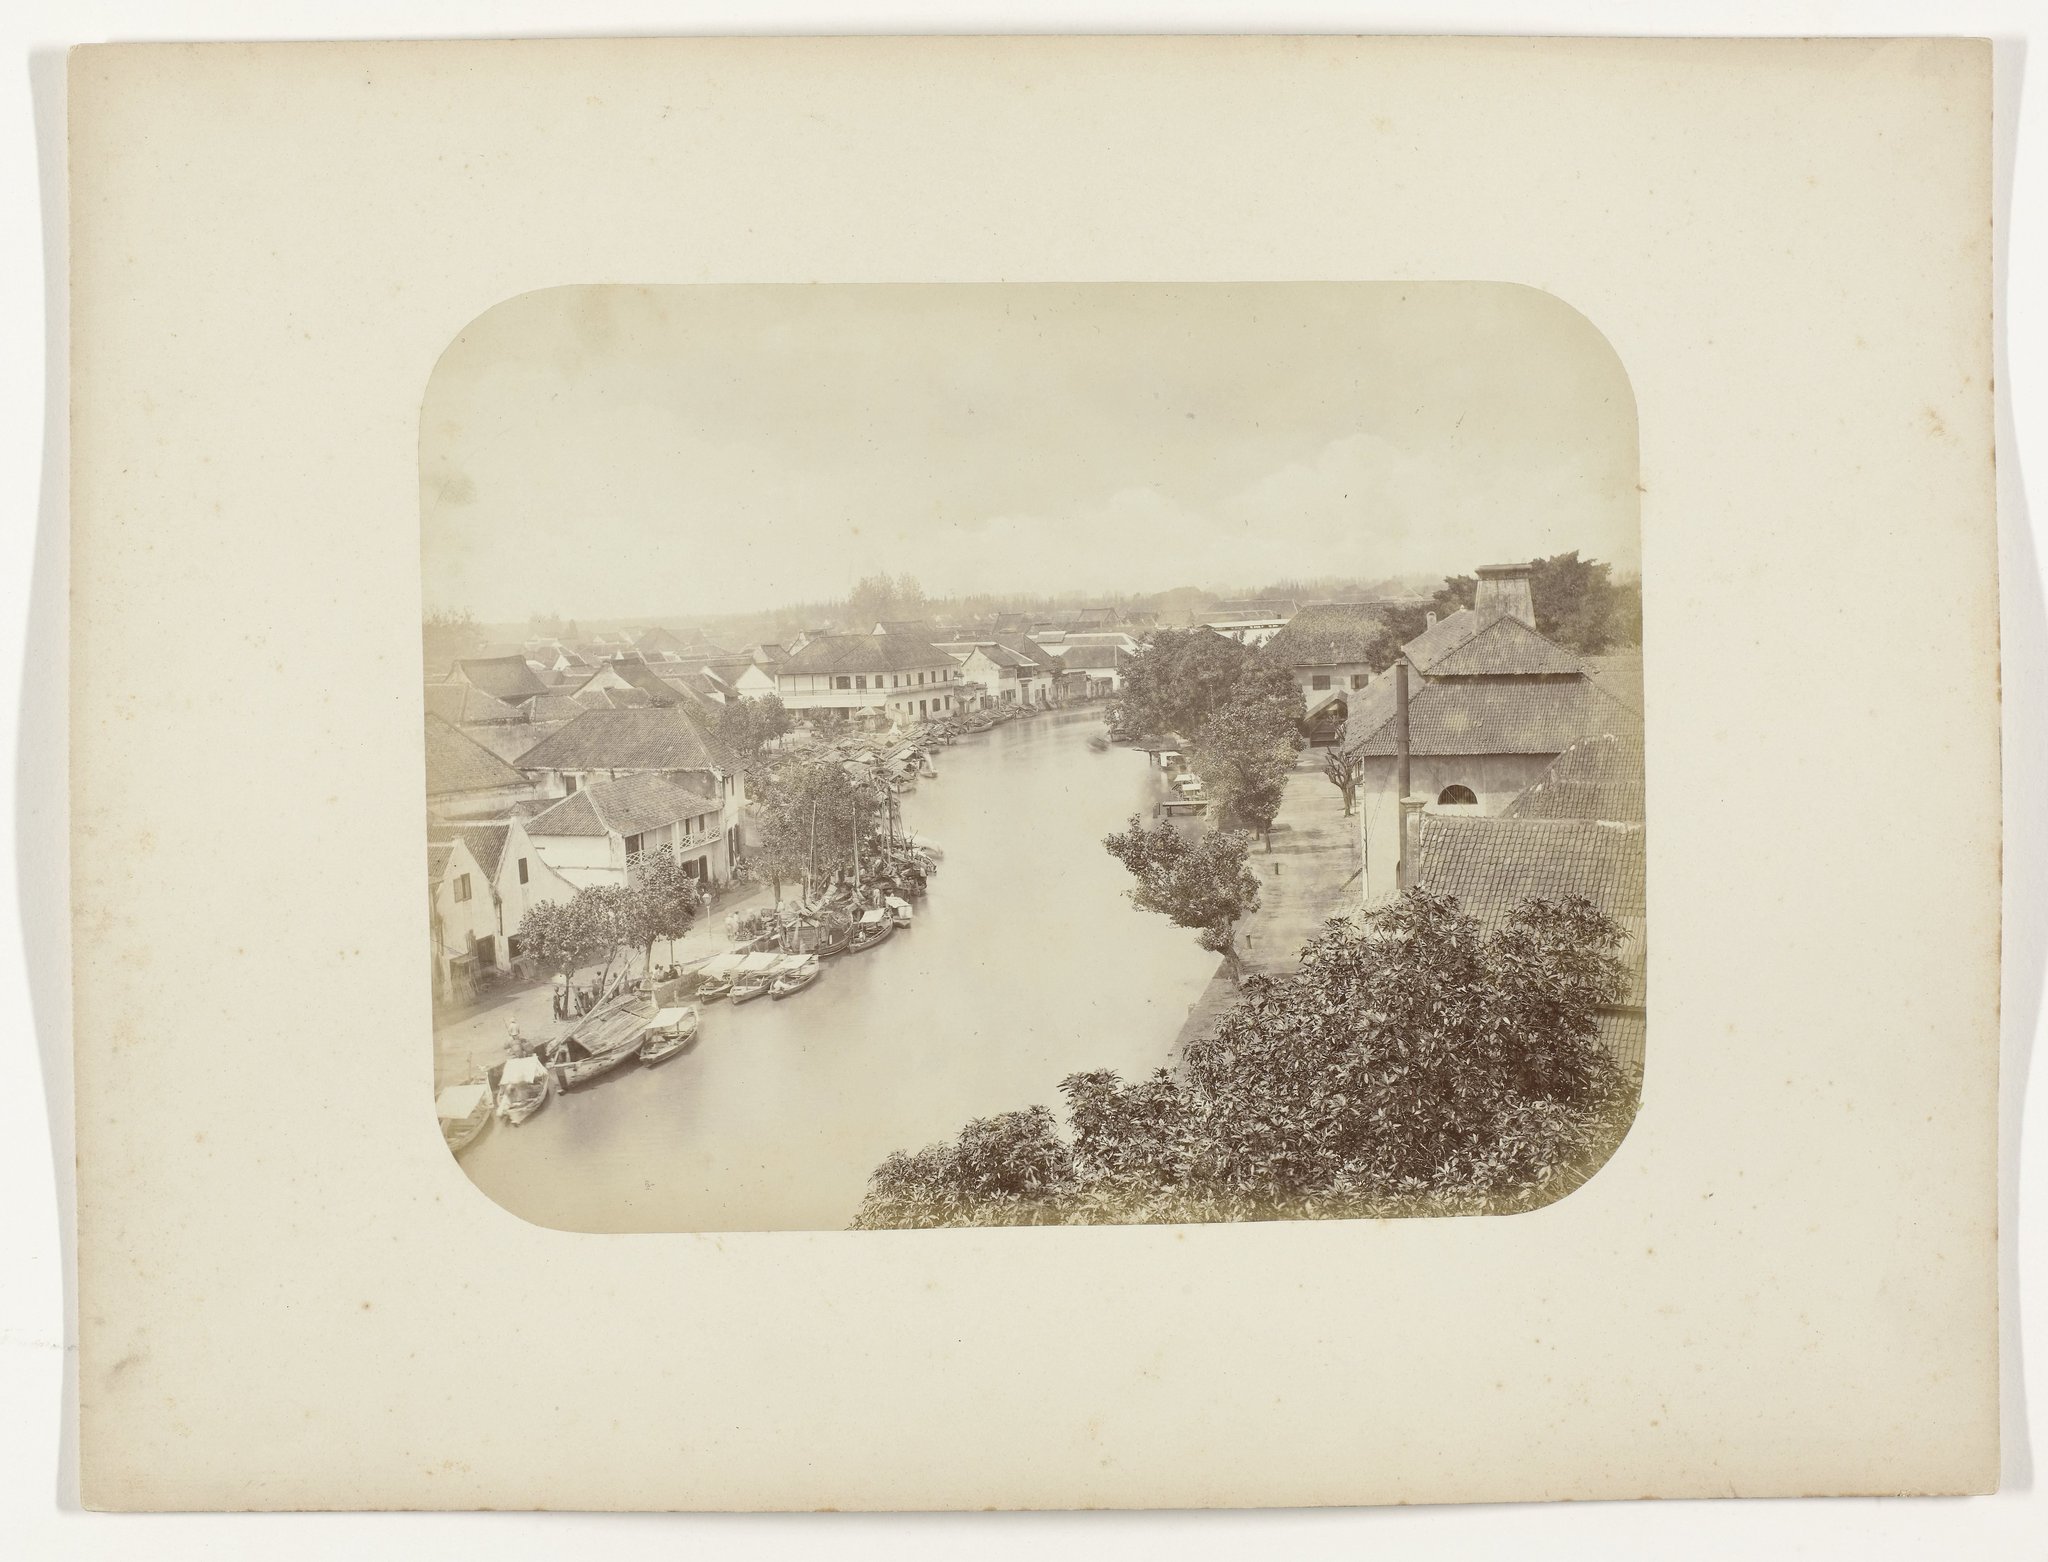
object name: photograph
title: Het handelscentrum met de Kali Mas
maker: herman salzwedel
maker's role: fotograaf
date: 1876-1884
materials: photographic support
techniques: albumen print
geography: surabaya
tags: utrecht, the hague, colonial system, river, locations for trading, public road, java, surabaya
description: Een overzicht van het handelscentrum met de Kali Mas naar de stad Soerabaja gezien. Onderdeel van het fotoalbum door de Soerabayasche Vereeniging van Suikerfabrikanten aangeboden aan Frederik Beyerinck, resident van Soerabaja.